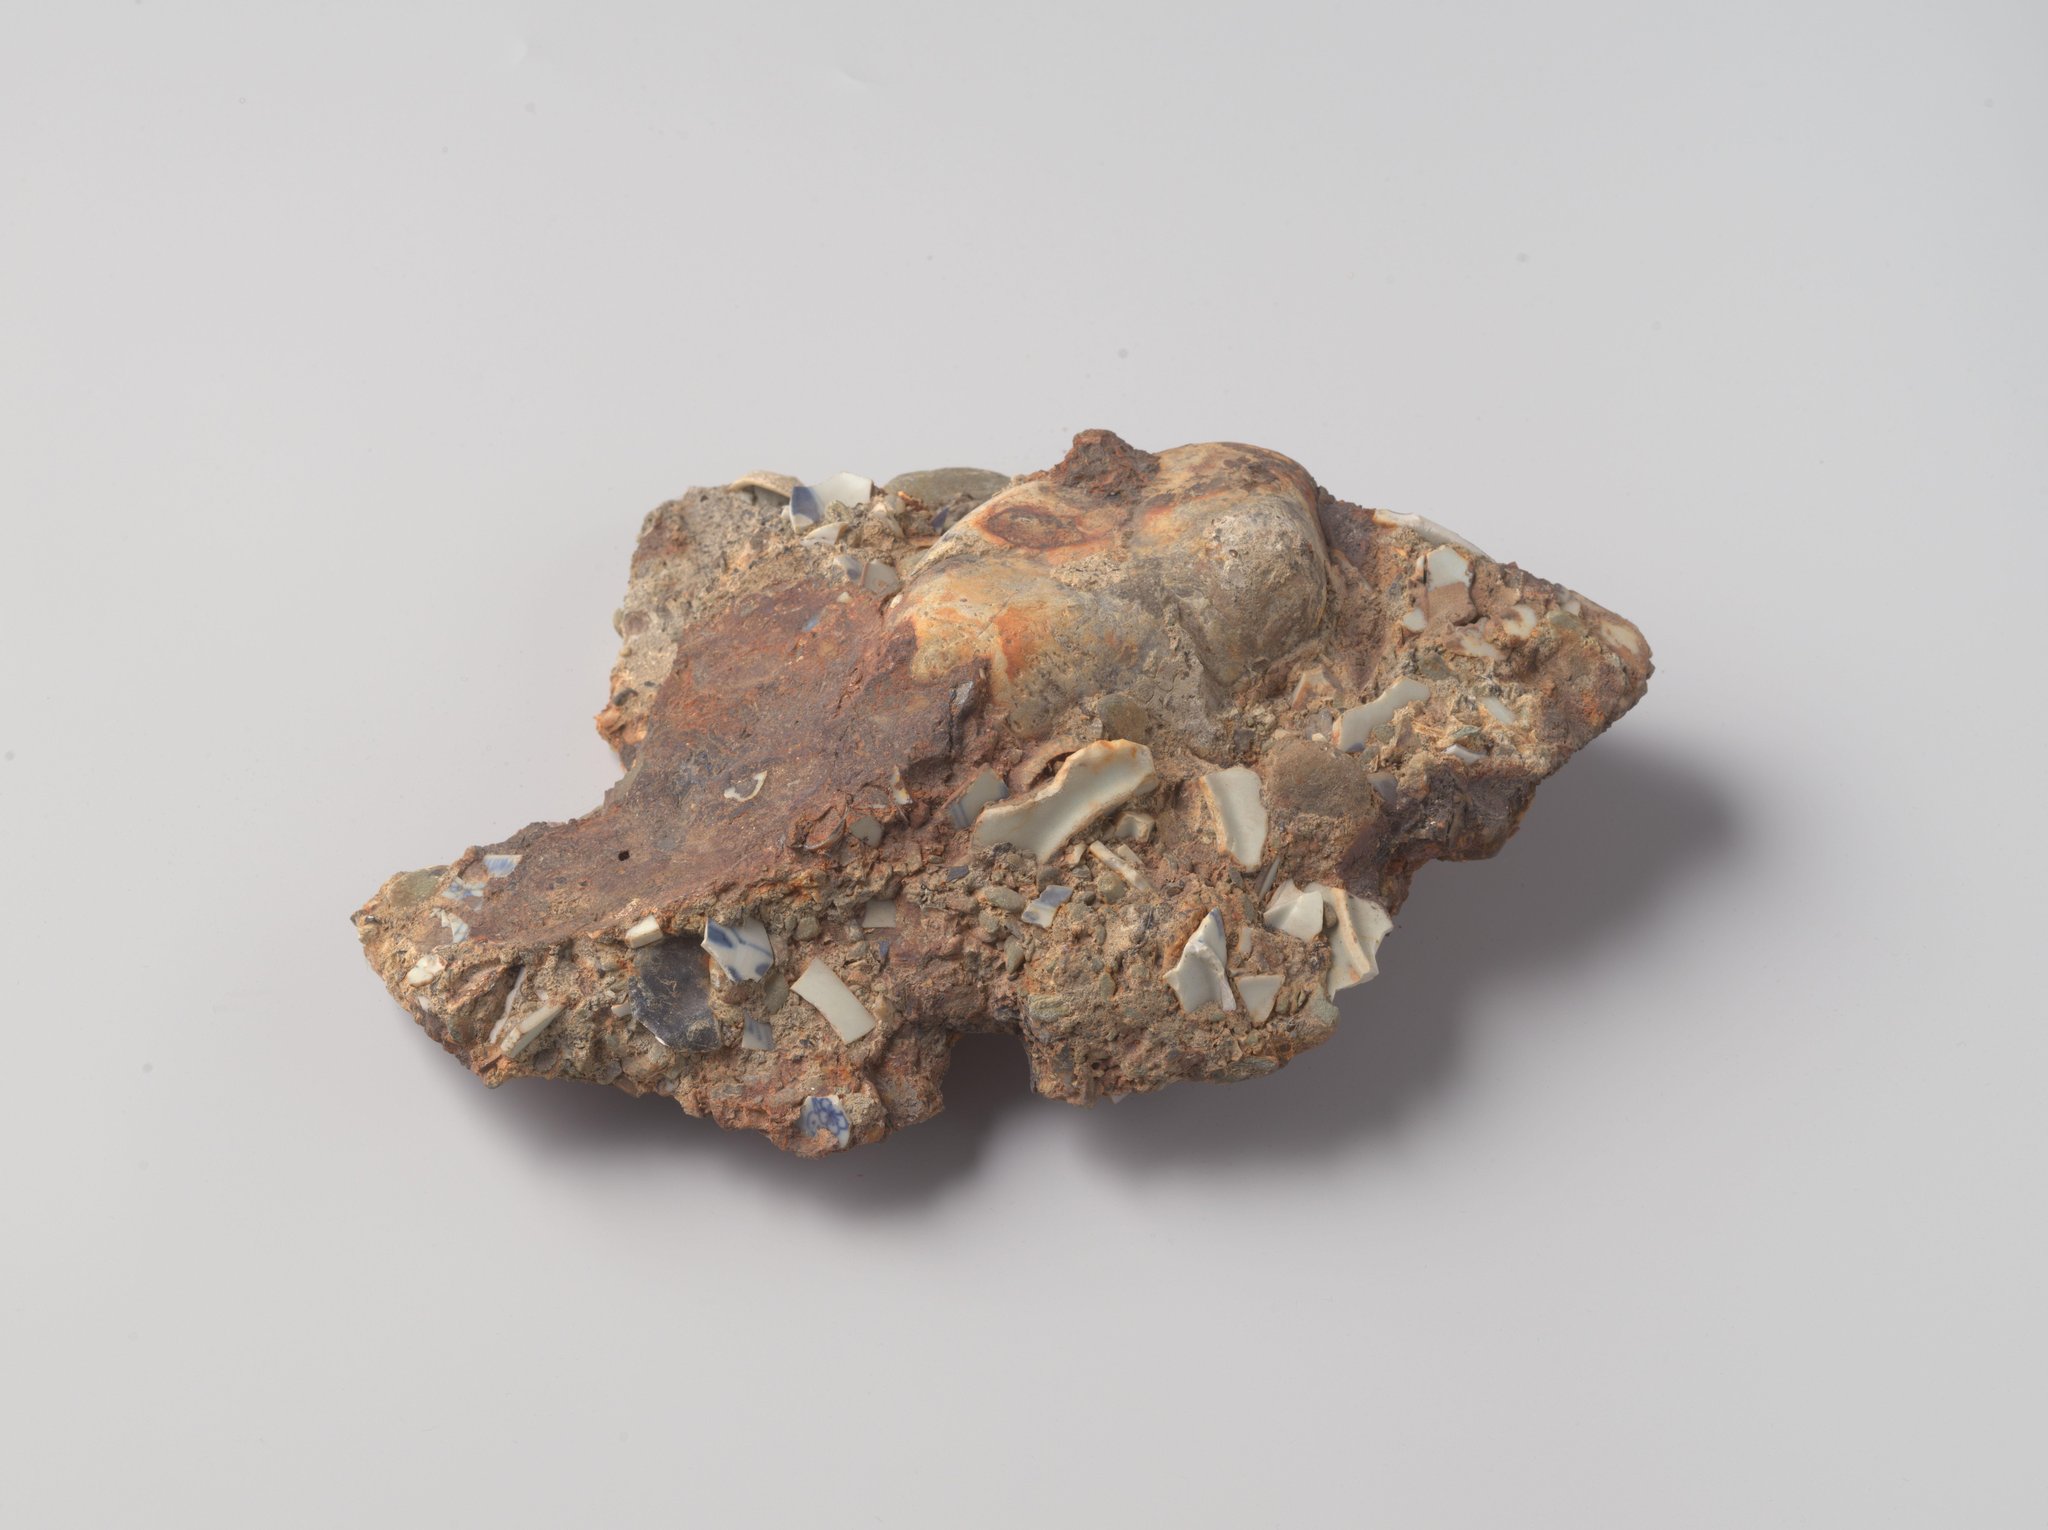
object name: concretionary stone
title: Brok concretie met insluitsels van natuursteen en porselein uit het wrak van de Oostindiëvaarder Hollandia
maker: Anonymous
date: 1700-1743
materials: stone, porcelain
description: Brok concretie met insluitsels van natuursteen en porselein.